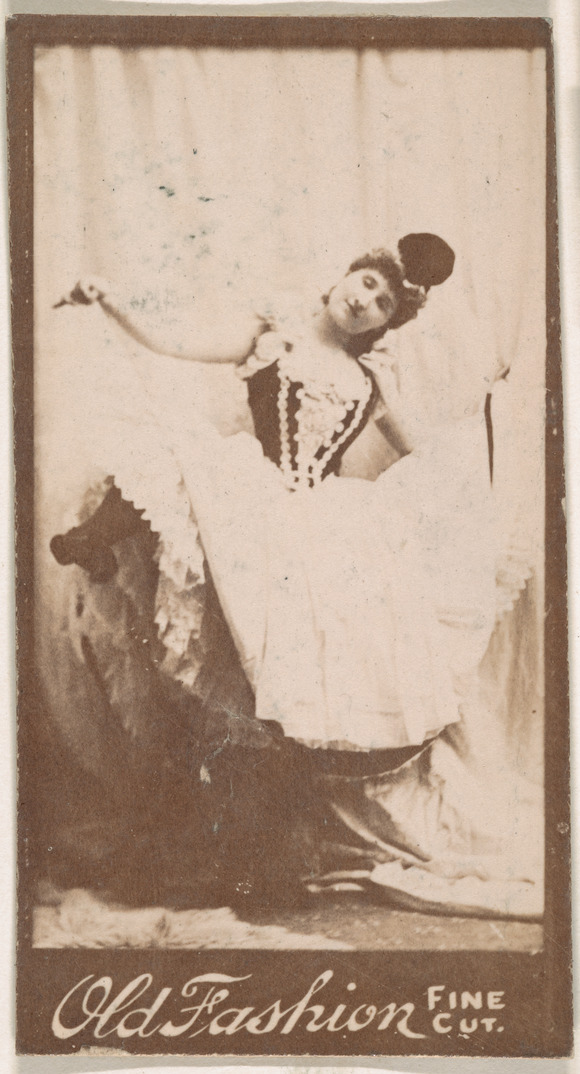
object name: photograph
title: Dancer, from the Actresses series (N664) promoting Old Fashion Fine Cut Tobacco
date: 1888-1890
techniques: albumen silver print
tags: portraits,women,actresses,dancers